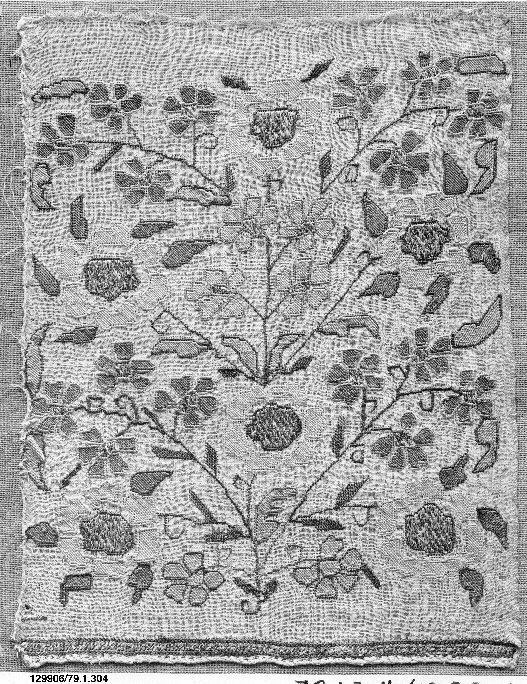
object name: towel end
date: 1801-1833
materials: linen, metal thread, silk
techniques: embroidery, weave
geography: turkey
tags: flowers